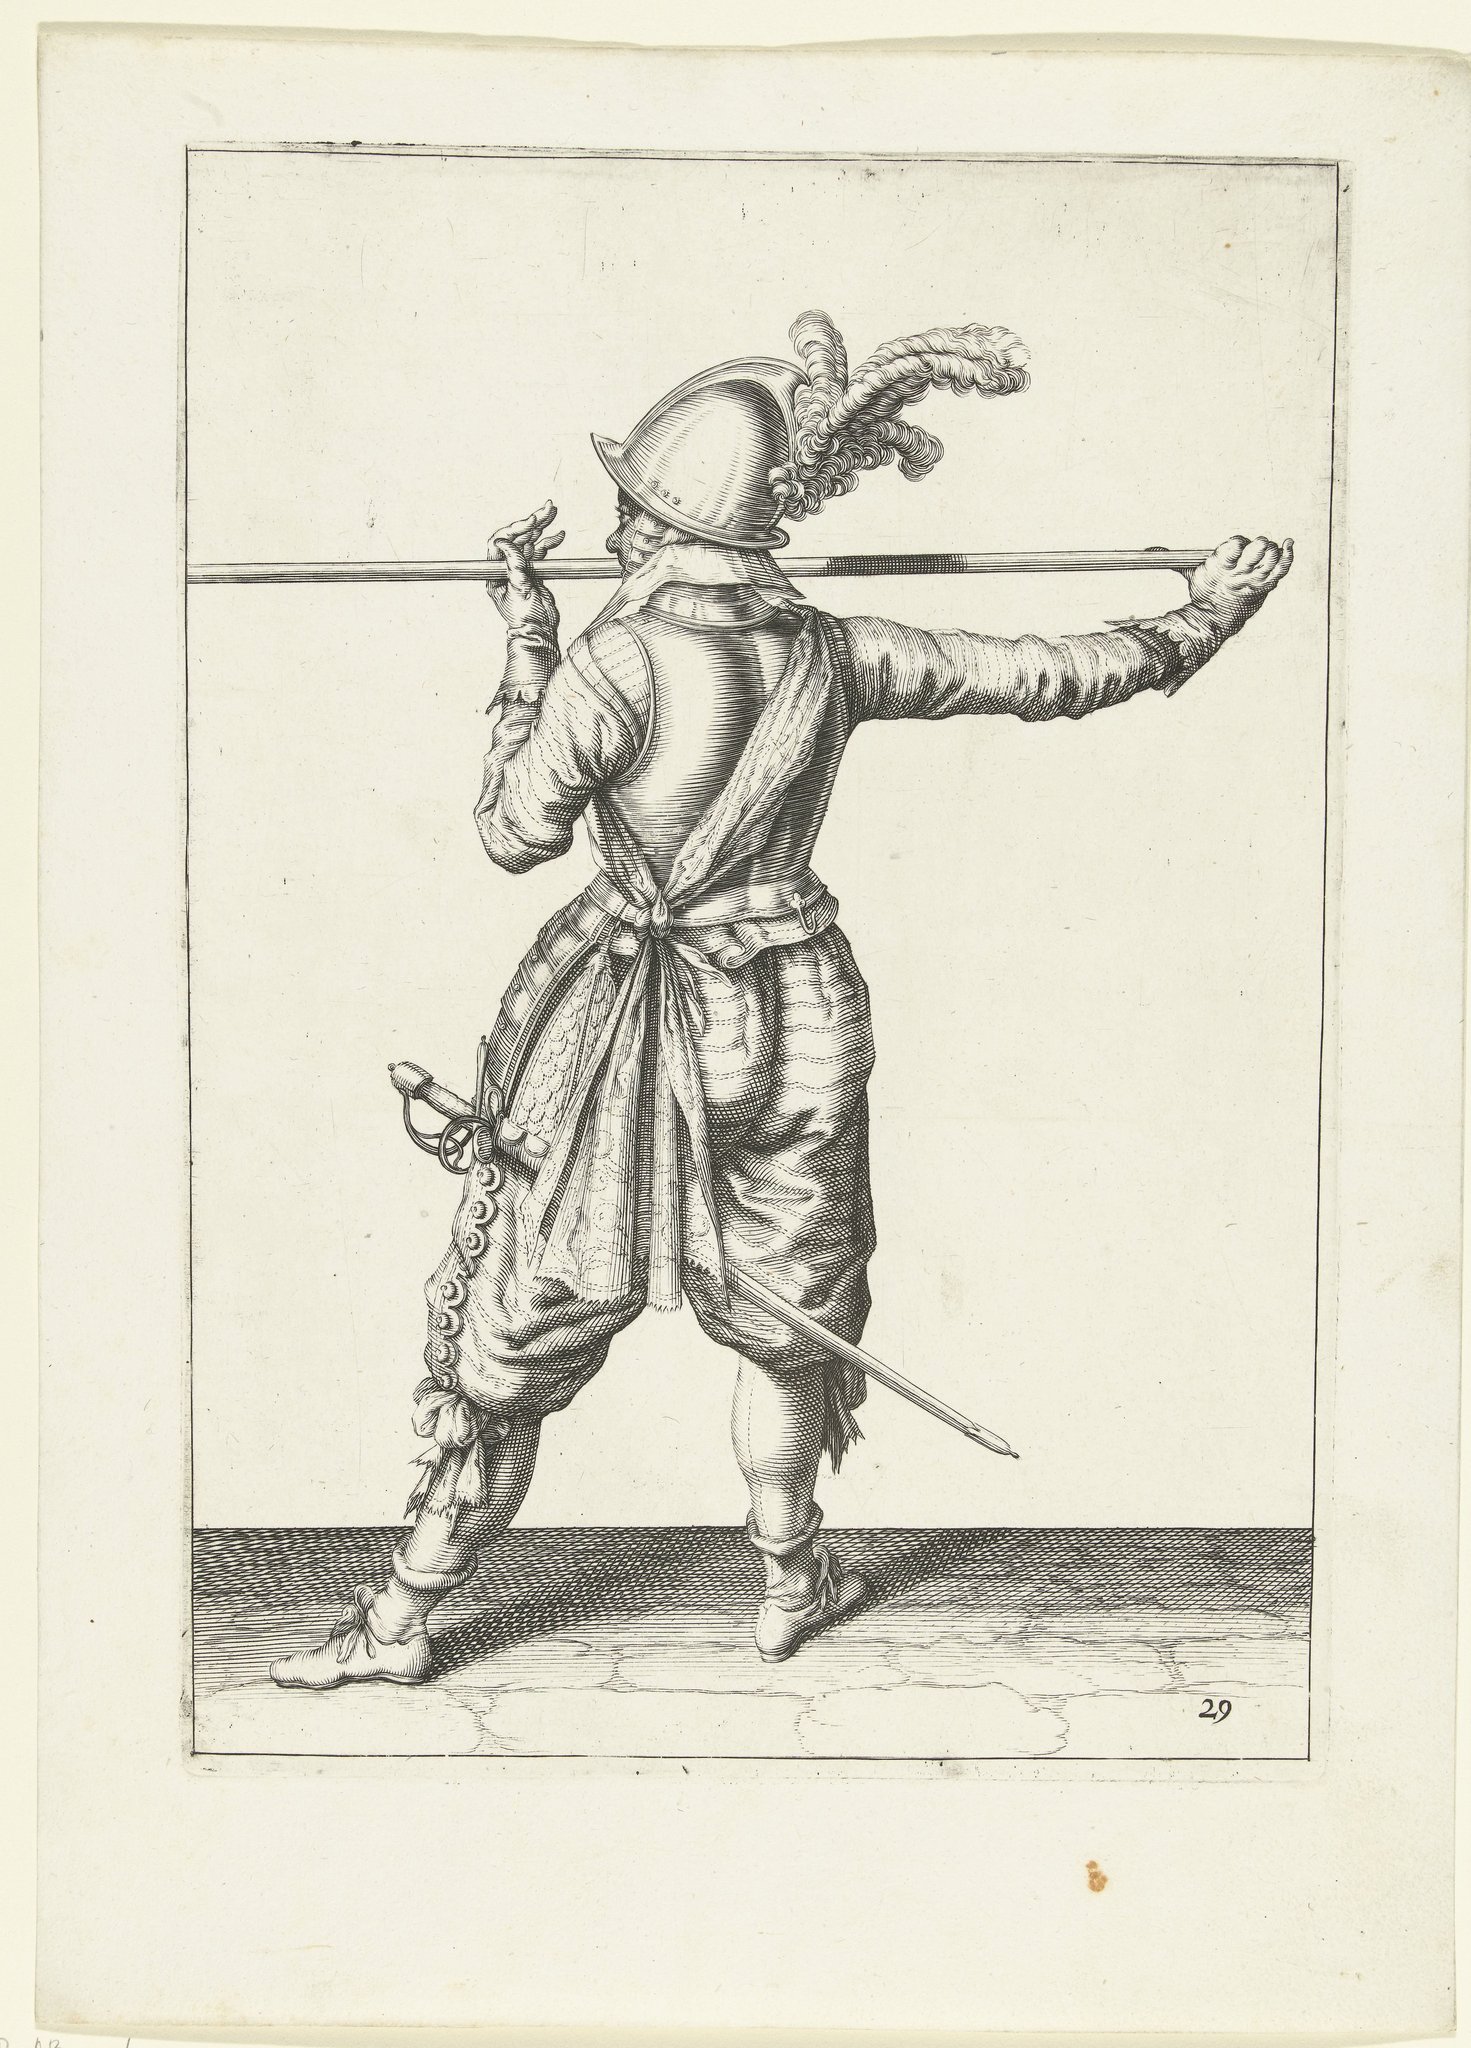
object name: print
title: Wapenhandelinghe van Roers Musquetten ende Spiessen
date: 1597-1607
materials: paper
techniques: engraving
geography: netherlands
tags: manoeuvre ~ military training, warfare; military affairs (+ mercenary troops, e.g.: lansquenets), helved weapons, polearms (for striking, hacking, thrusting): lance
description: Een soldaat, ten voeten uit, op de rug gezien, die een spies (lans) met beide handen horizontaal op neushoogte draagt, zijn rechterhand bij de voet van het wapen, zijn gezicht naar links gewend. Deze prent is onderdeel van de reeks van 32 genummerde prenten van spiesdragers uit de Wapenhandelinghe.